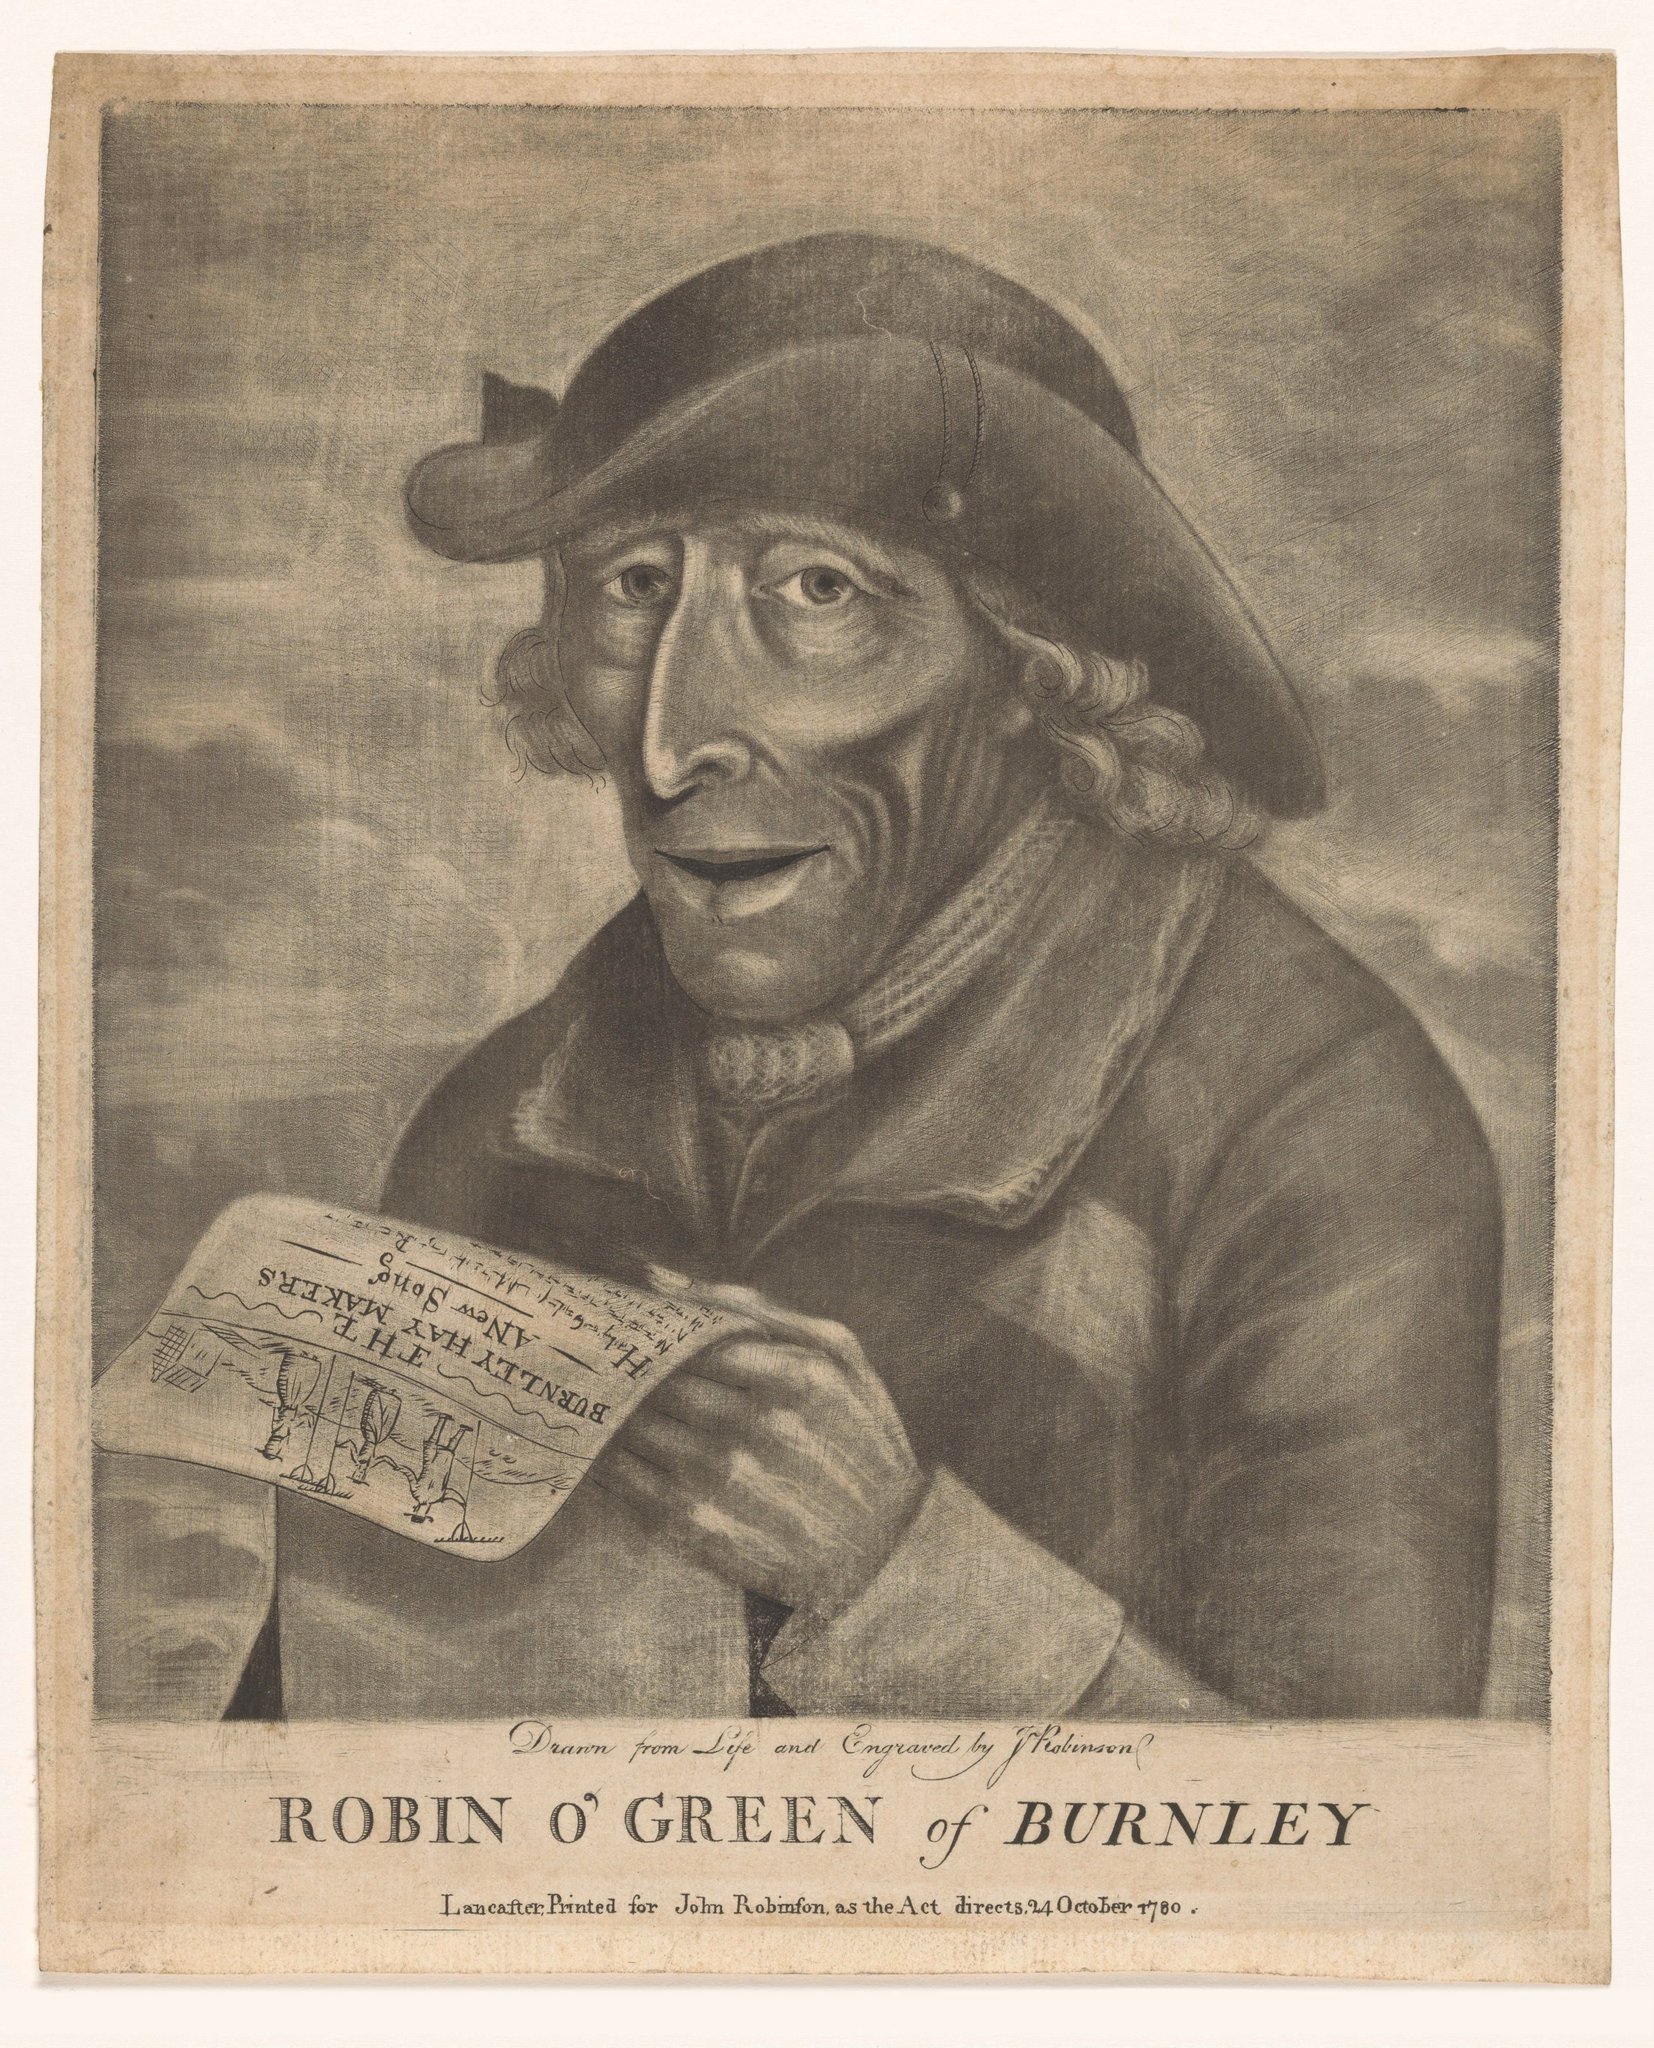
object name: print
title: Portret van Robin O'Green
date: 1780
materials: paper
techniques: engraving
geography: lancaster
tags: ballad singer, ballad seller - cc - out of doors, agricultural implements: rake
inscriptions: collector's mark: Lugt 4780, collector's mark: Lugt 2228, collector's mark: Lugt 4779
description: Staand, ten halven lijve geportretteerd. In zijn hand houdt hij een lied: "The Burnley Hay Makers. A New Song" met een illustratie van twee vrouwen en een man met harken.